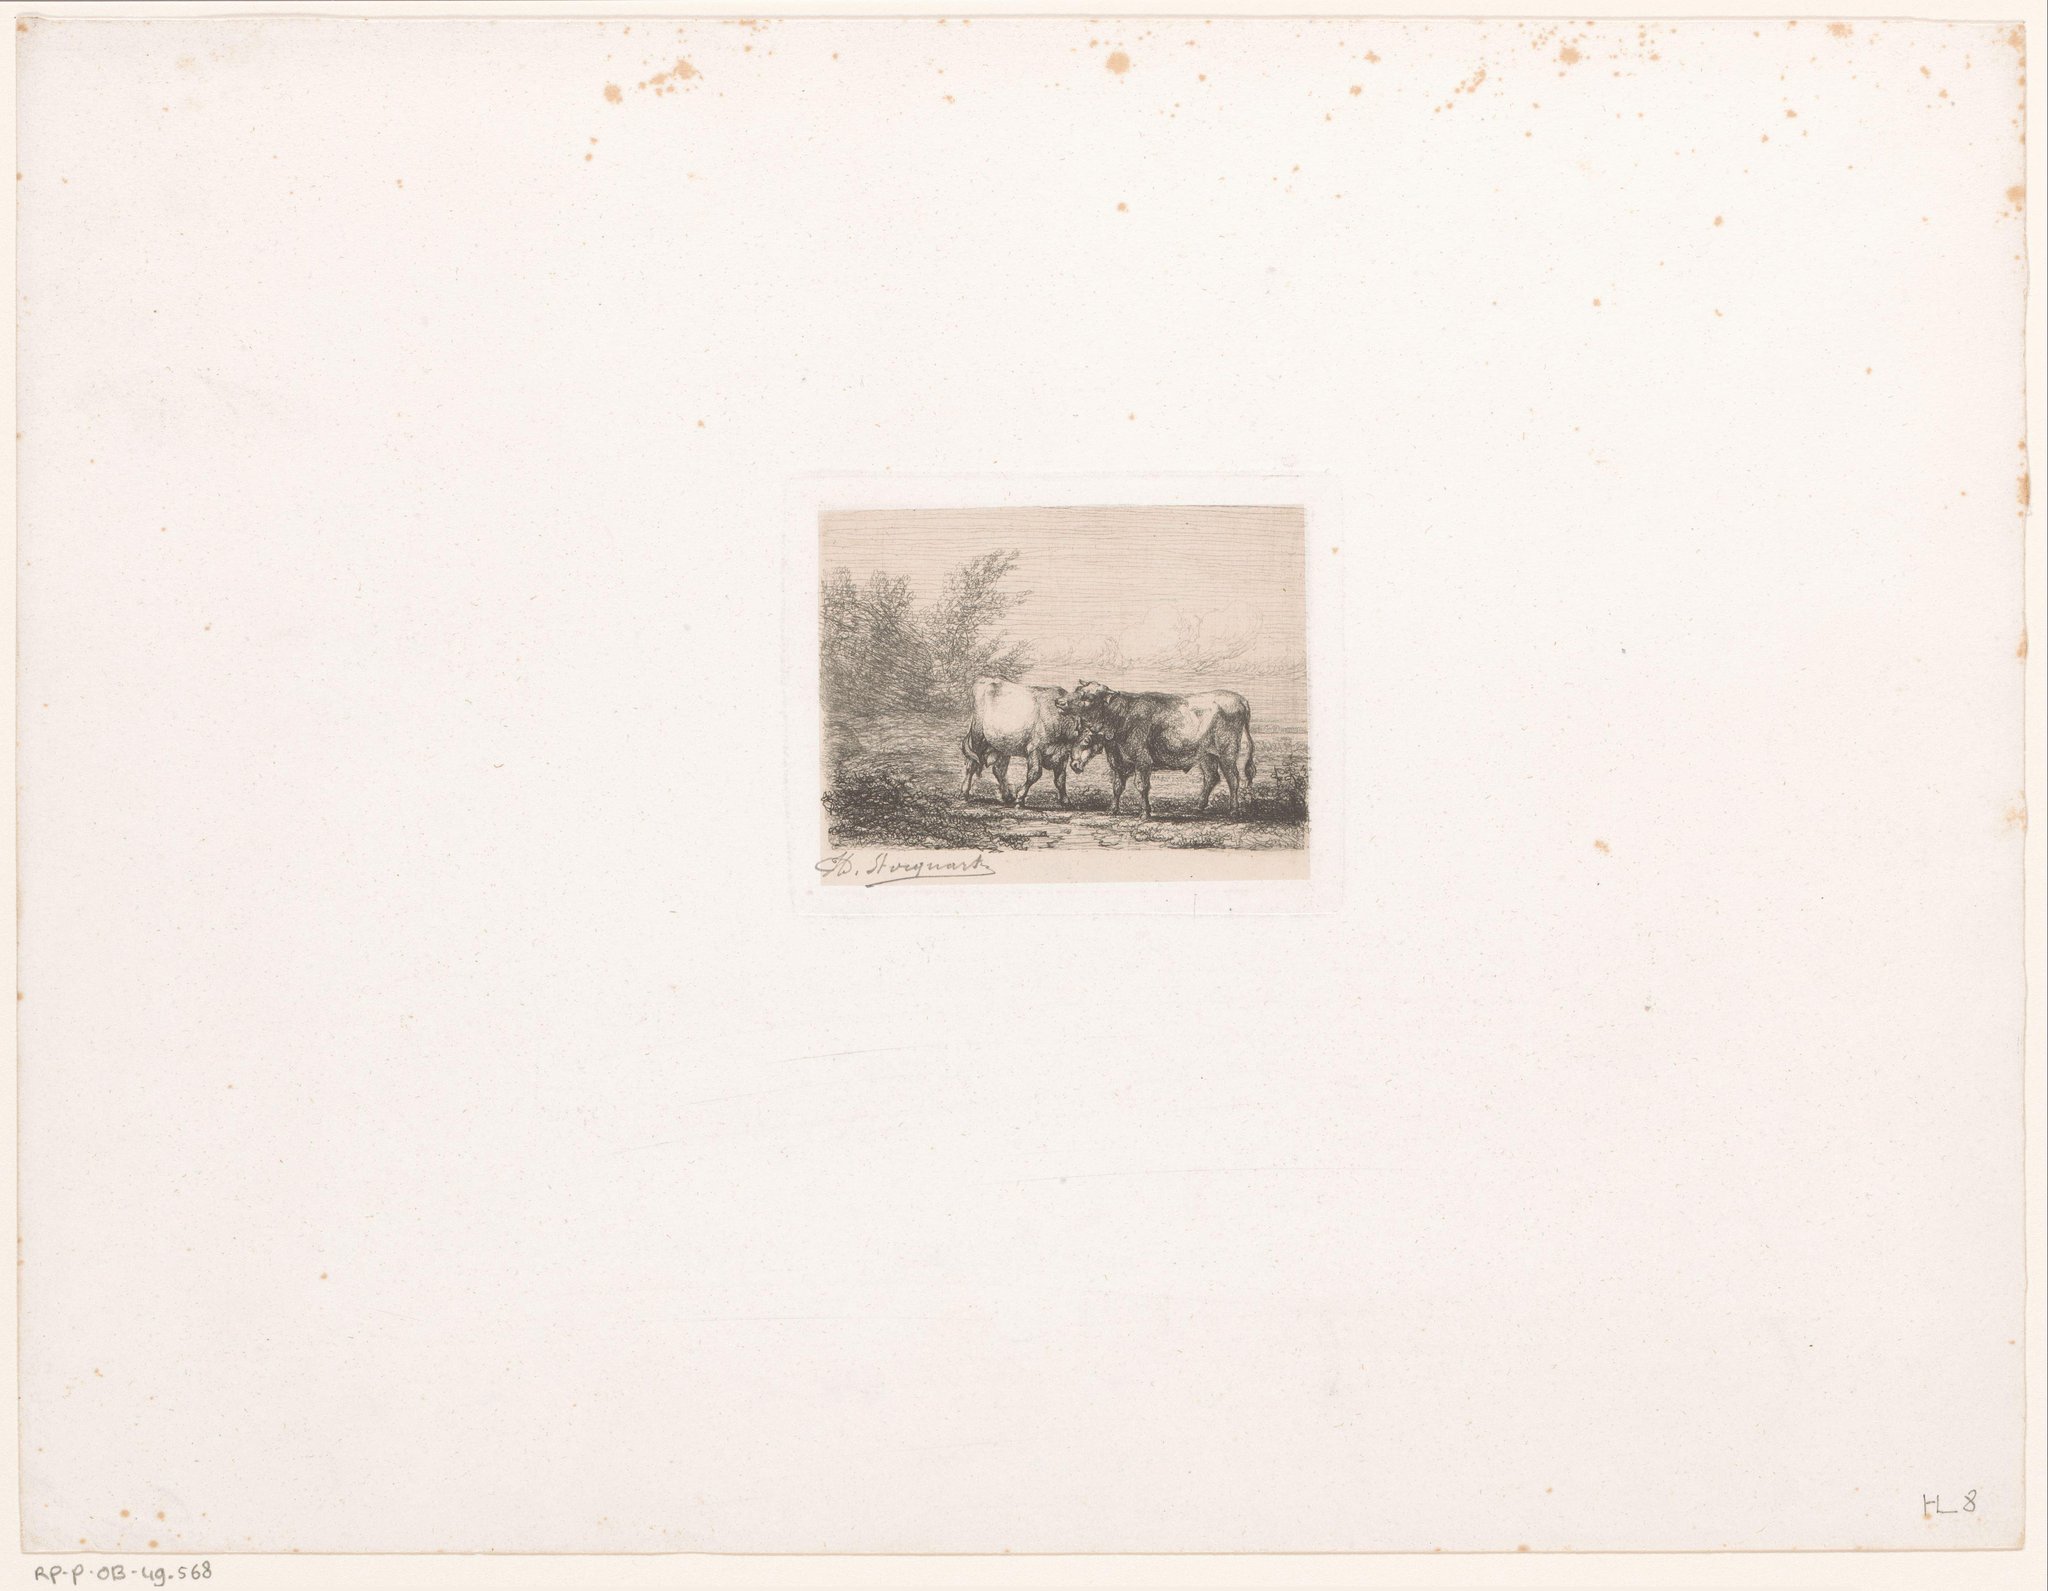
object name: print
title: Twee koeien met de koppen bij elkaar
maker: ildephonse stocquart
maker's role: print maker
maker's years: 1819-1889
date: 1829-1879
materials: paper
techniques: etching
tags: cow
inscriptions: collector's mark: Lugt 2228